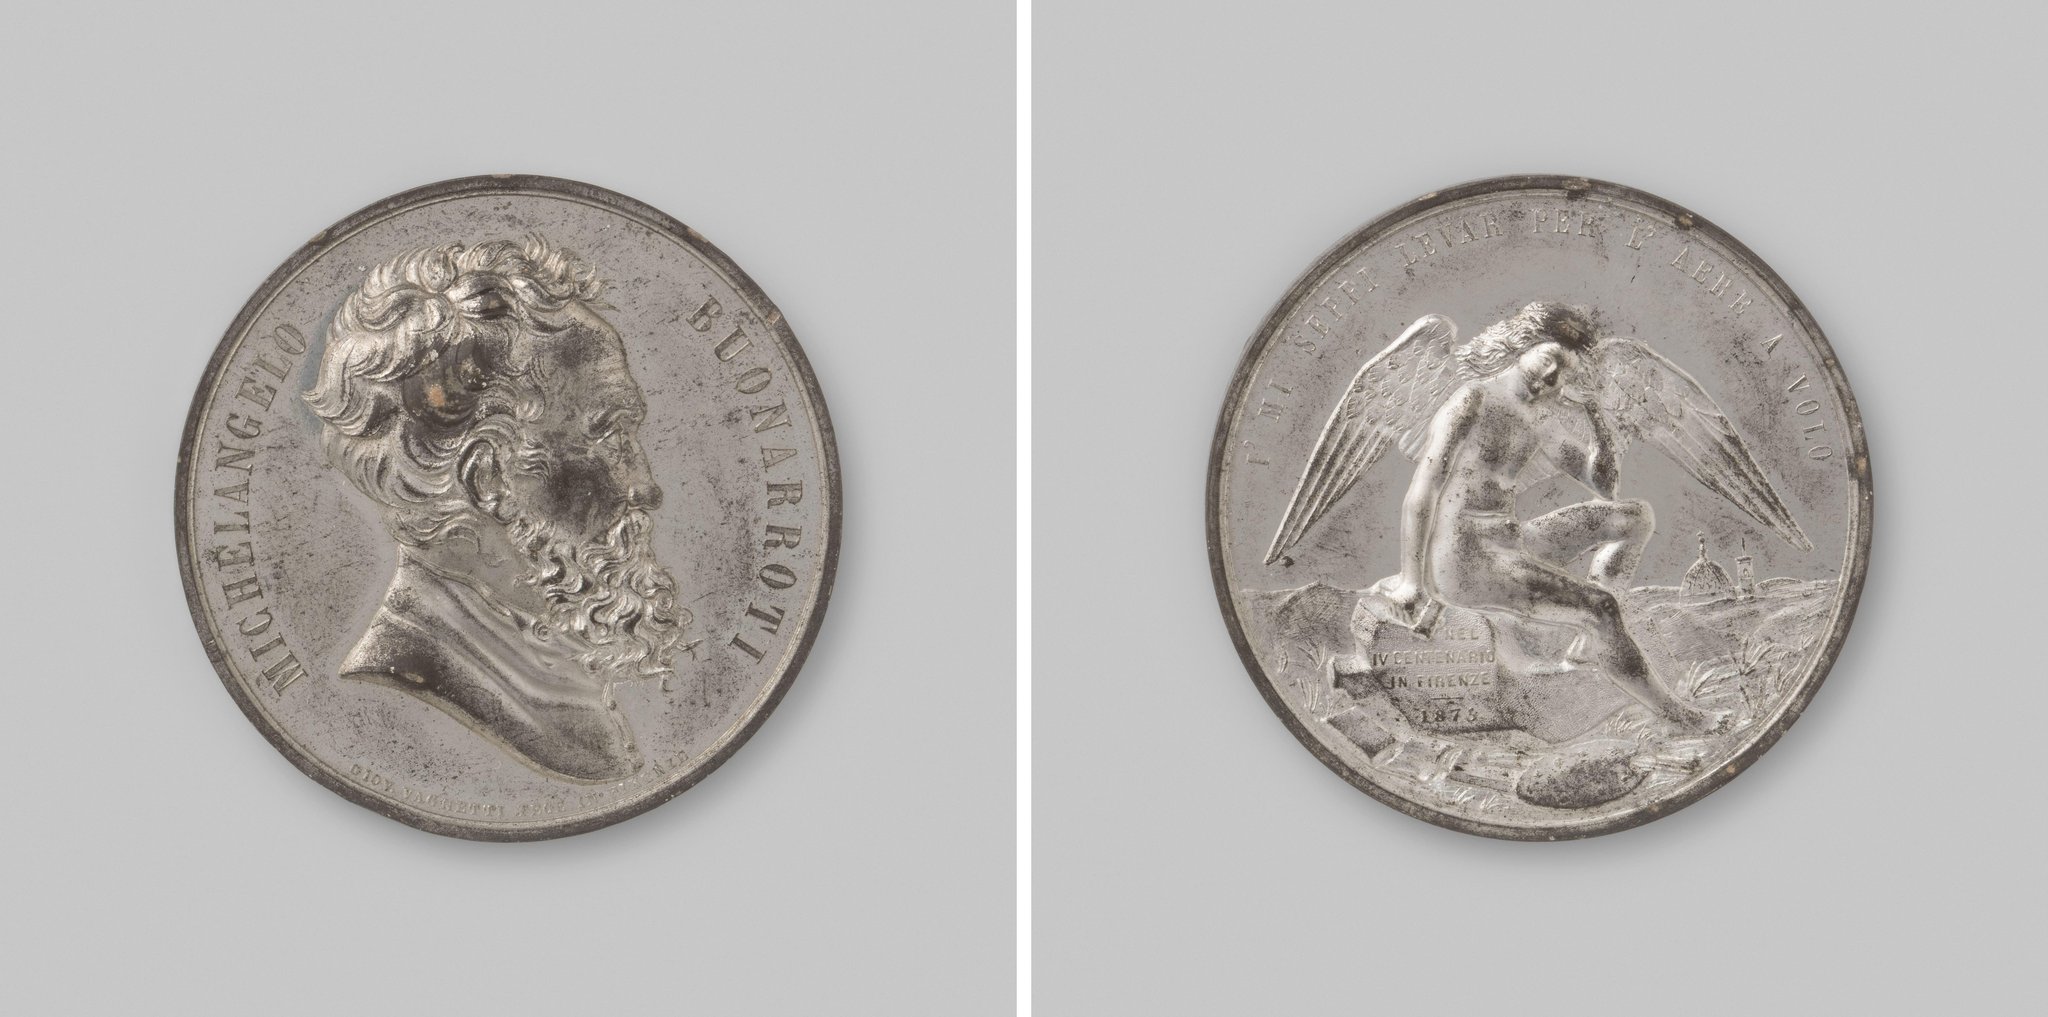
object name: history medal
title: Vierhonderdjarig herdenking van de geboorte van Michelangelo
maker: giovanni vagnetti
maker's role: medailleur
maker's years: 1840-1890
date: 1875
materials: silver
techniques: striking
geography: florence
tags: rome, painter, draughtsman, sculptor, michelangelo